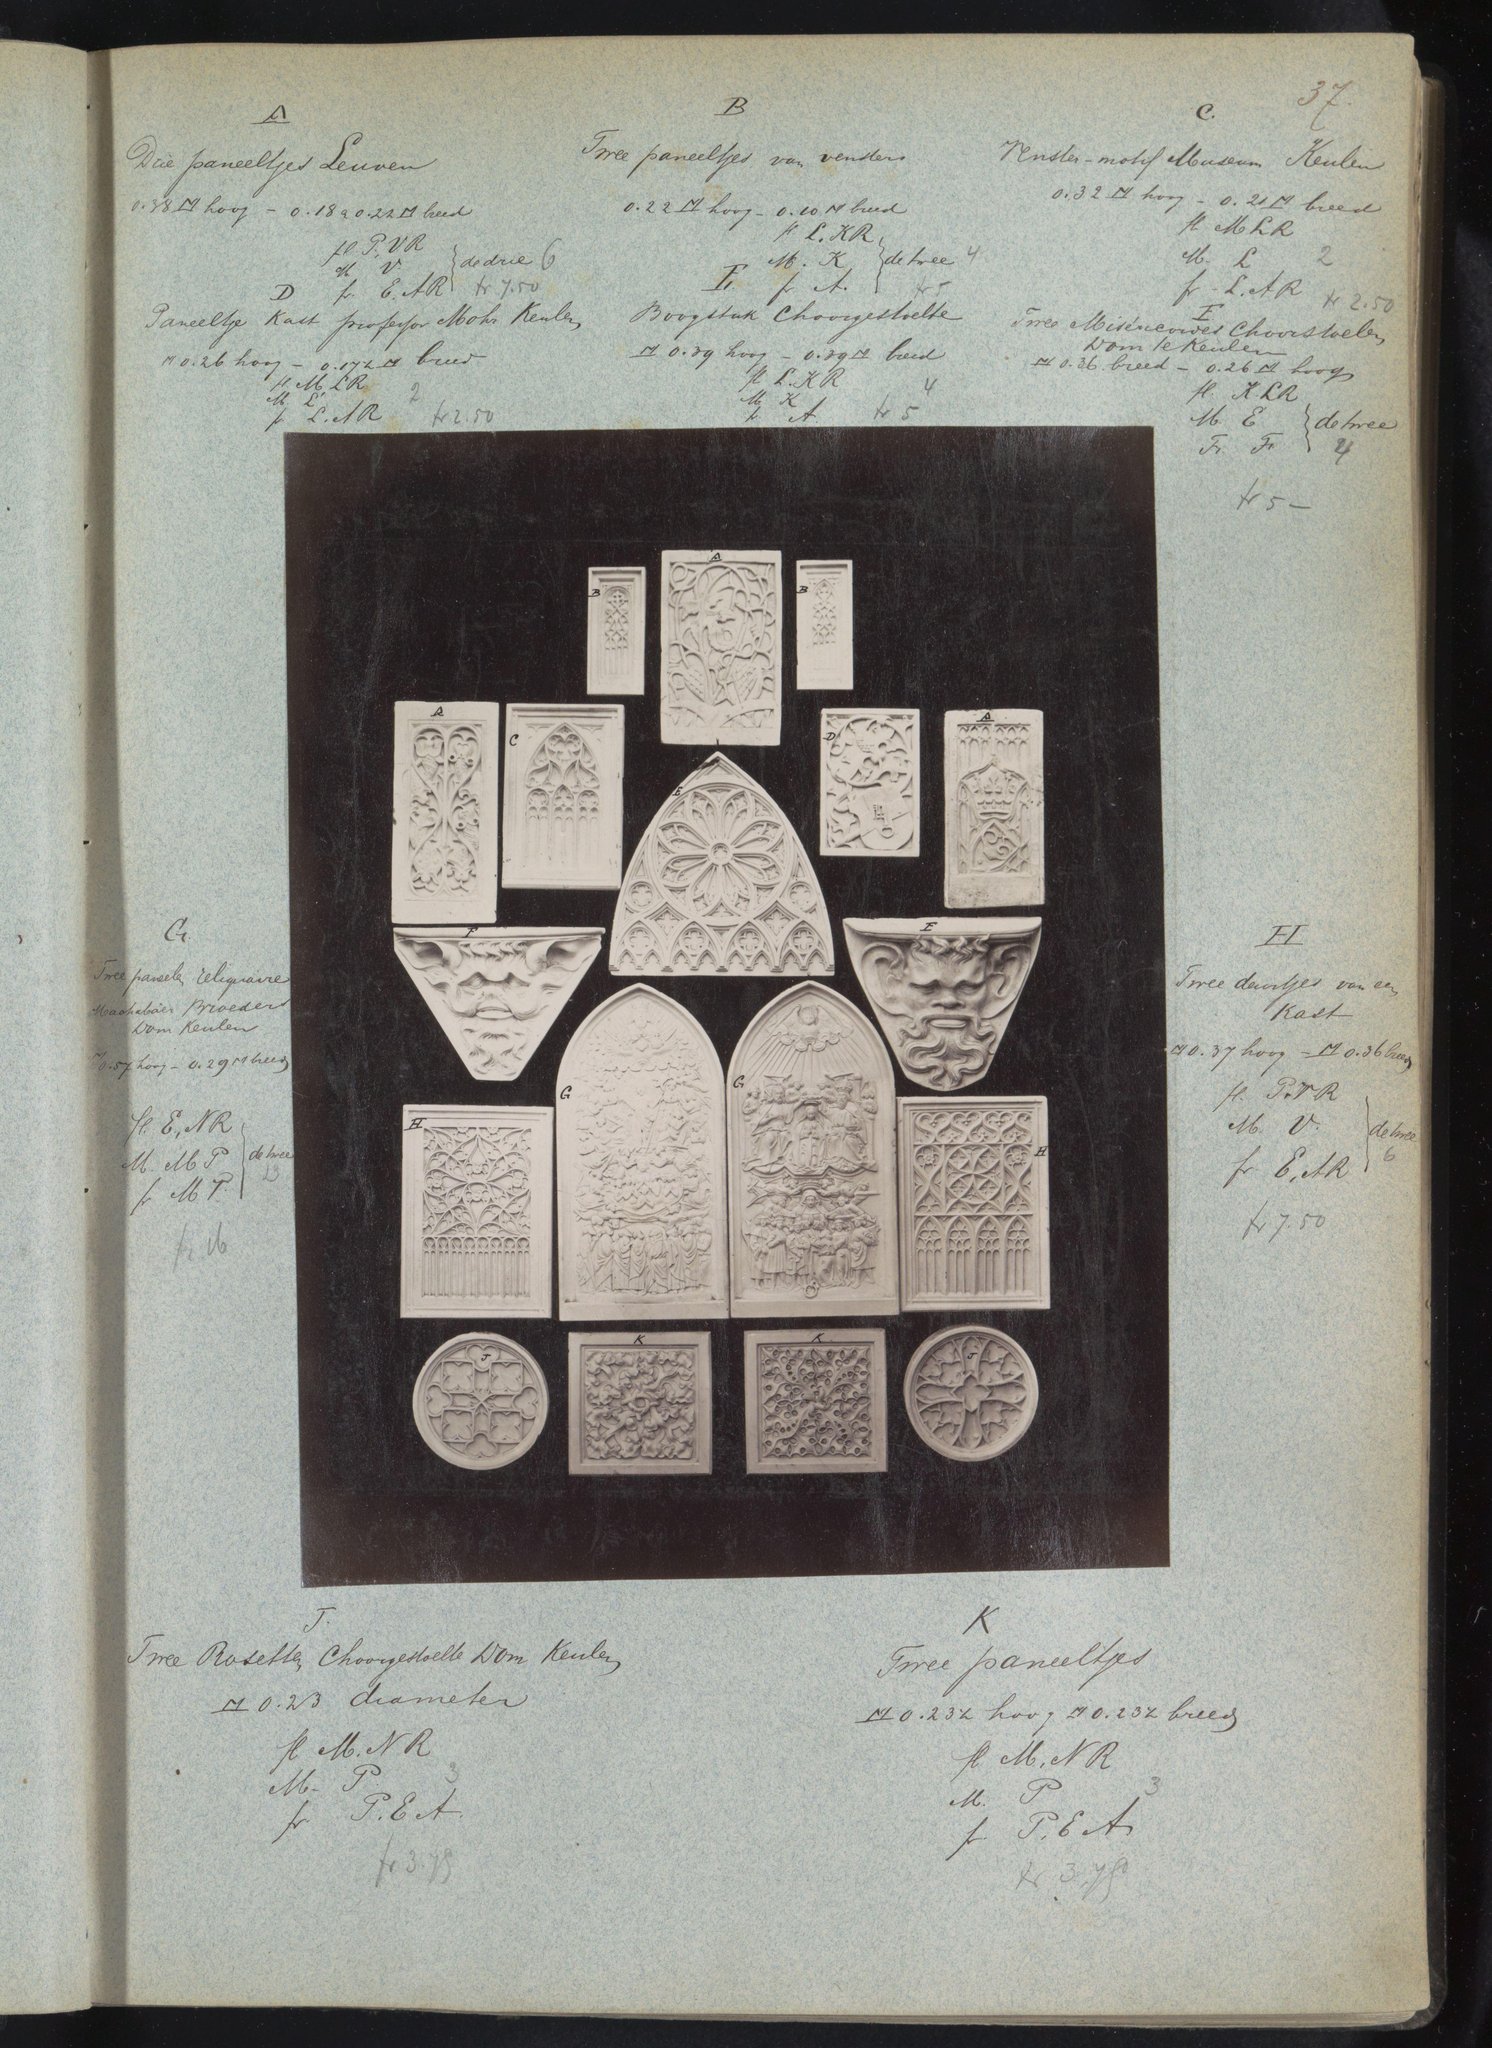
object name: album leaf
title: Gipsen afgietsels van onder meer paneeltjes en rozetten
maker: Anonymous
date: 1875-1900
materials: paper, photographic support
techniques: albumen print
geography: rotterdam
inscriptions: annotation, annotation